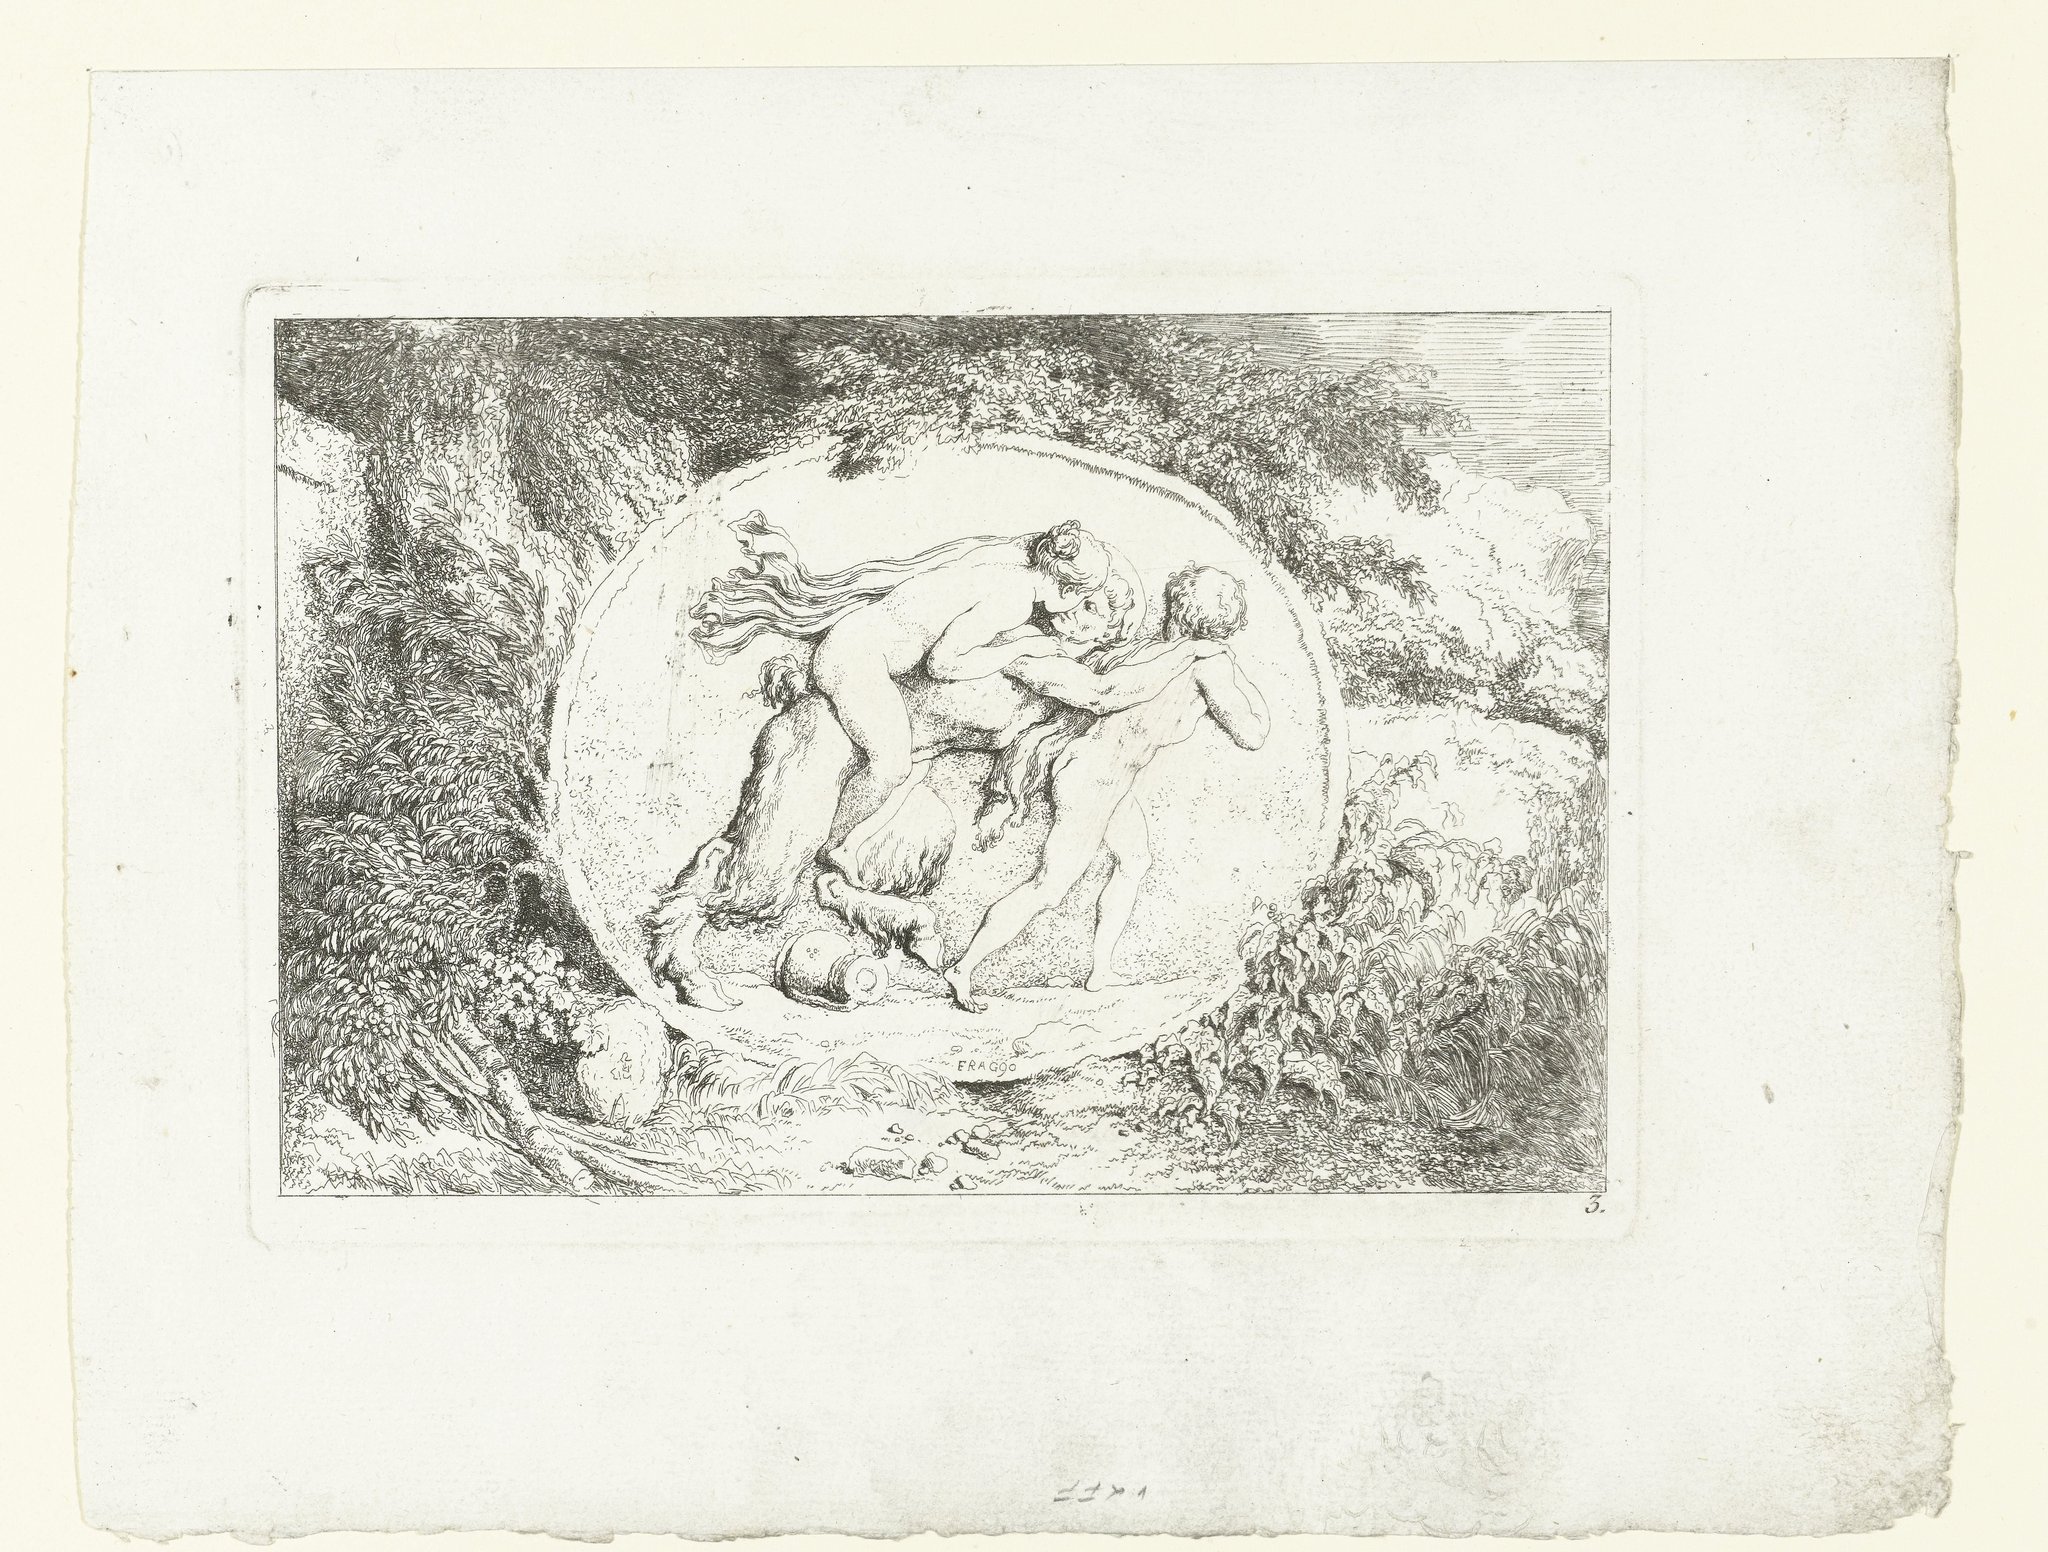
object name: print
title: Jonge vrouw op de rug van een sater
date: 1763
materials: paper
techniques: etching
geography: italy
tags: non-aggressive, friendly or neutral activities and relationships of satyr(s), nymphs (in general); 'ninfe in commune' (ripa), art (+ relief ~ sculpture)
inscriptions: collector's mark: Lugt 2228, collector's mark: Lugt 2760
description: Een ovale bas-reliëf, staand op de grond tussen het groen, met een afbeelding van een sater met twee jonge vrouwen, waarvan één schrijlings op zijn rug zit en hem kust.